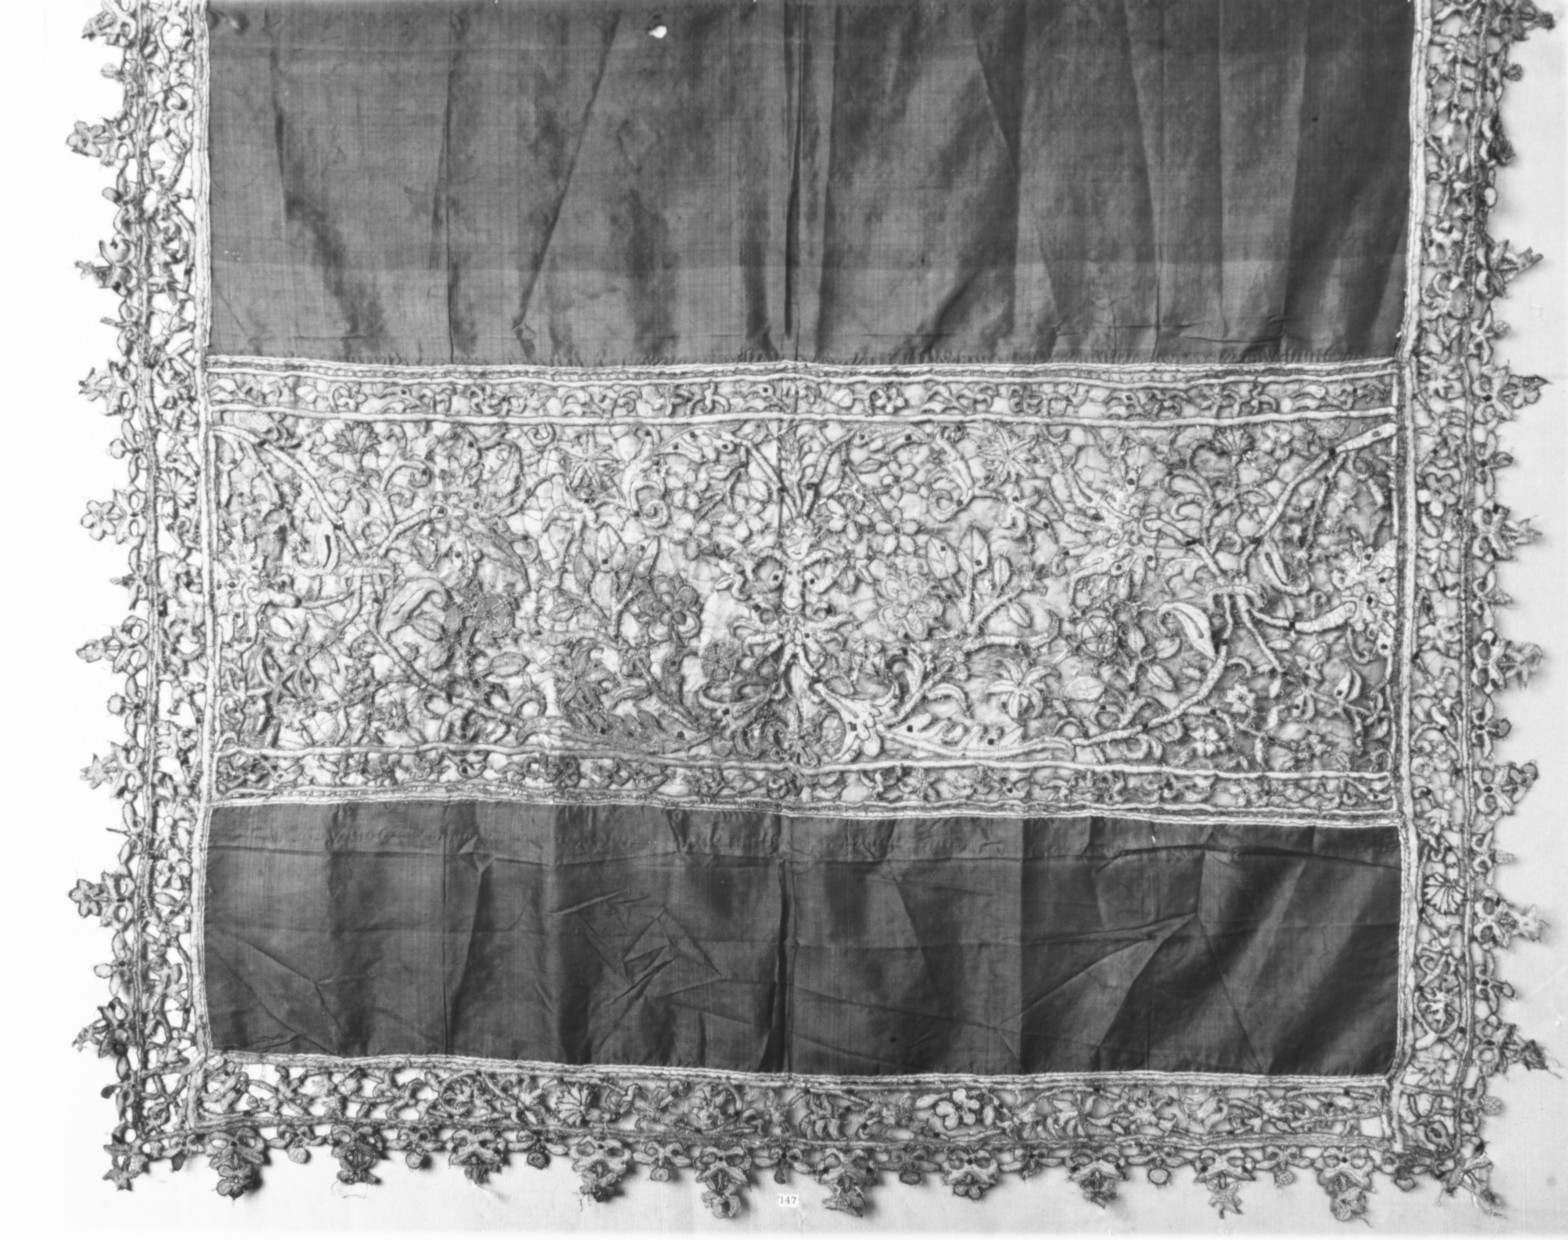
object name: veil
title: Baptismal veil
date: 1601-1633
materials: metal thread, silk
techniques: embroidery